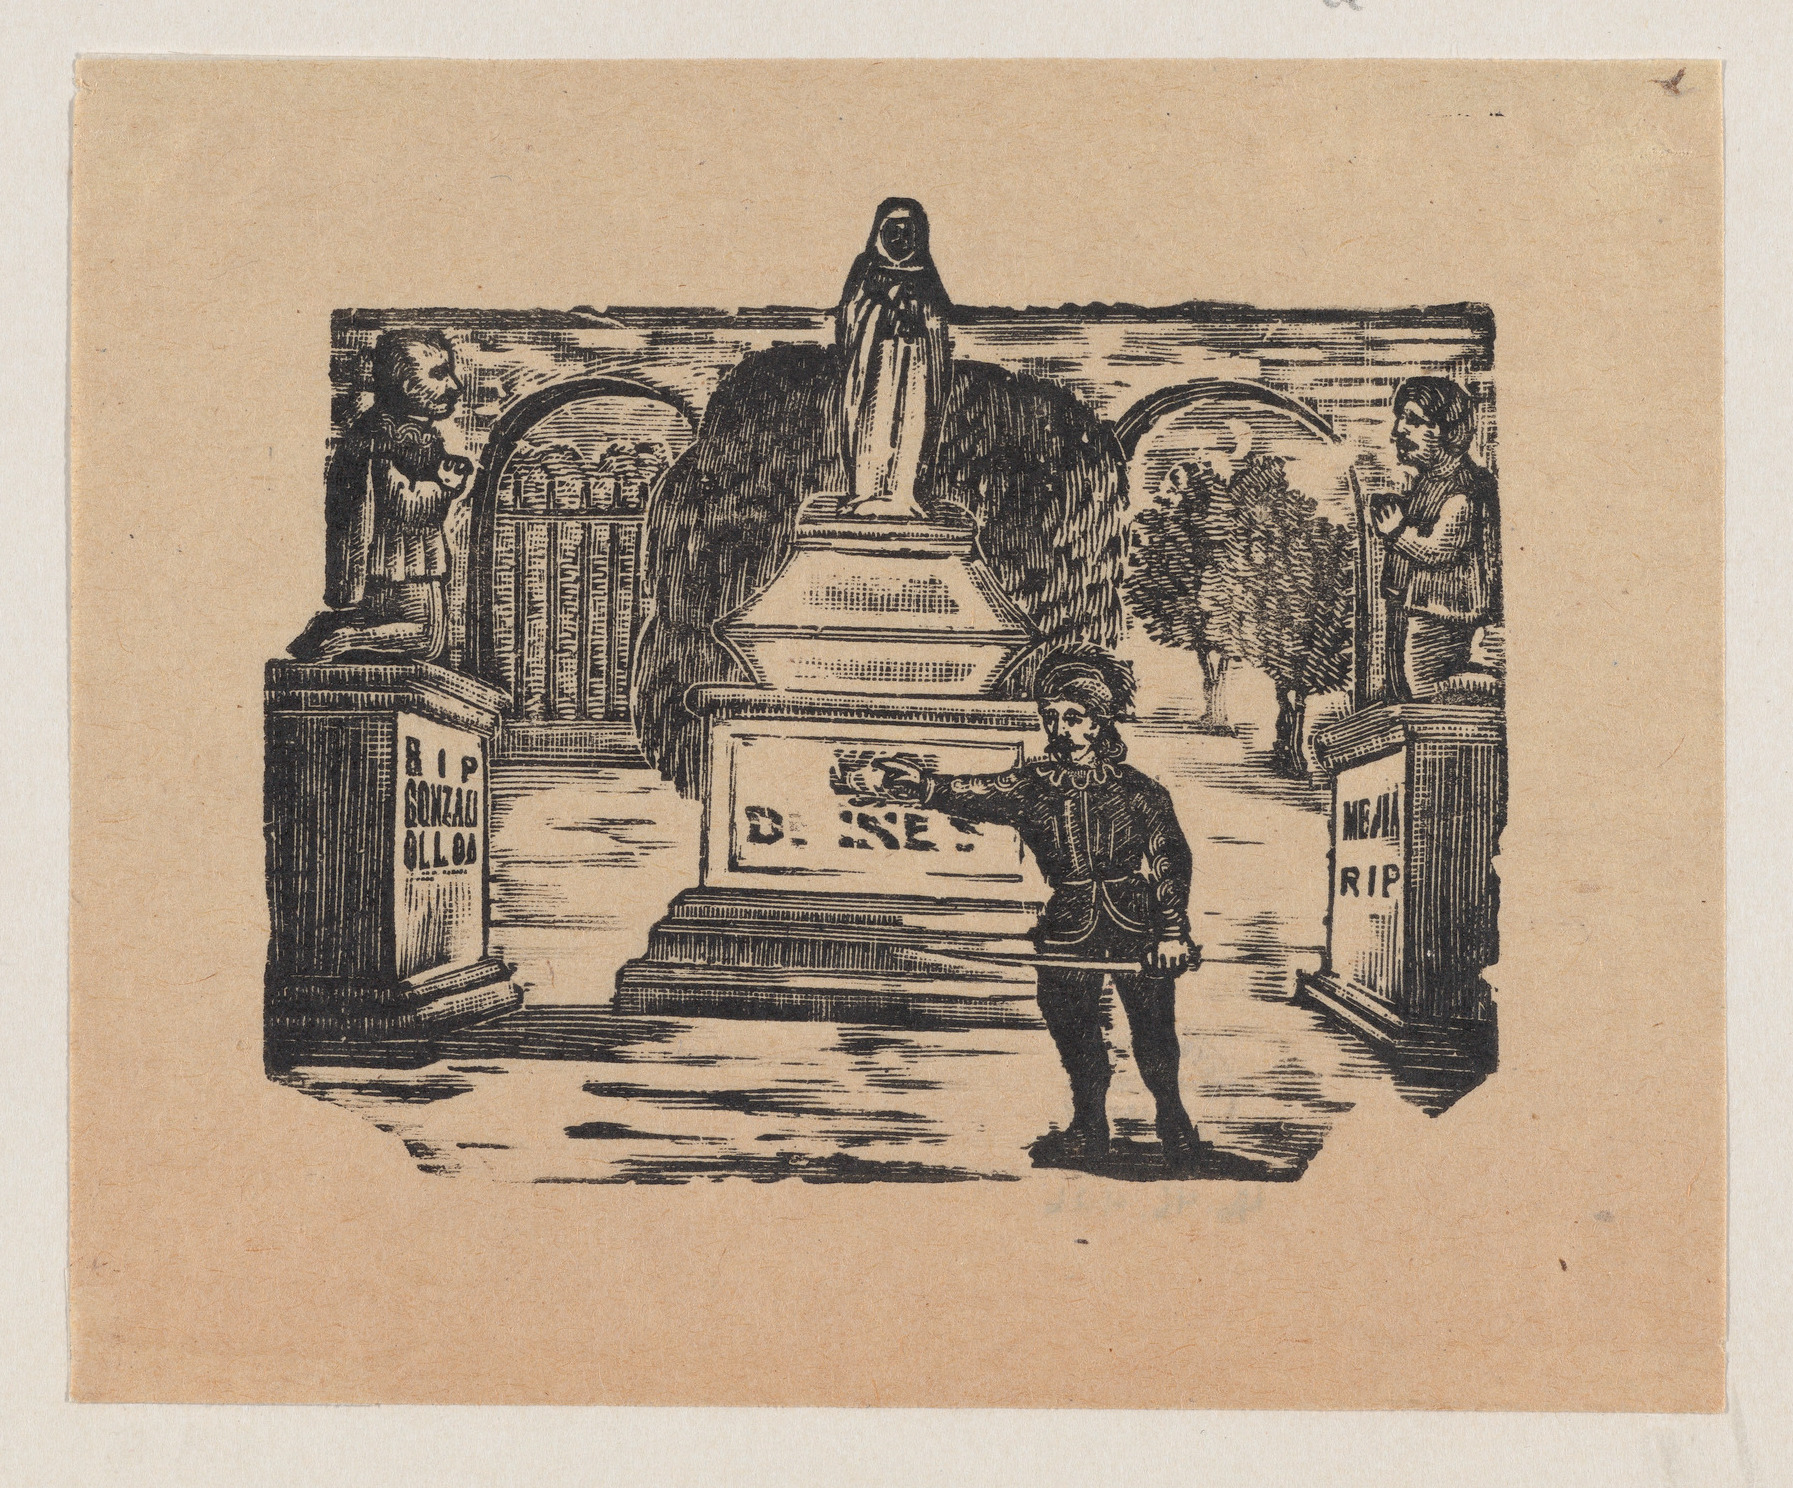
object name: print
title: A man standing in front of three monuments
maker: josé guadalupe posada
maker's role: artist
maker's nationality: mexican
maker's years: 1852-1913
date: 1890-1910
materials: metal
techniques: engraving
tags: monuments,men